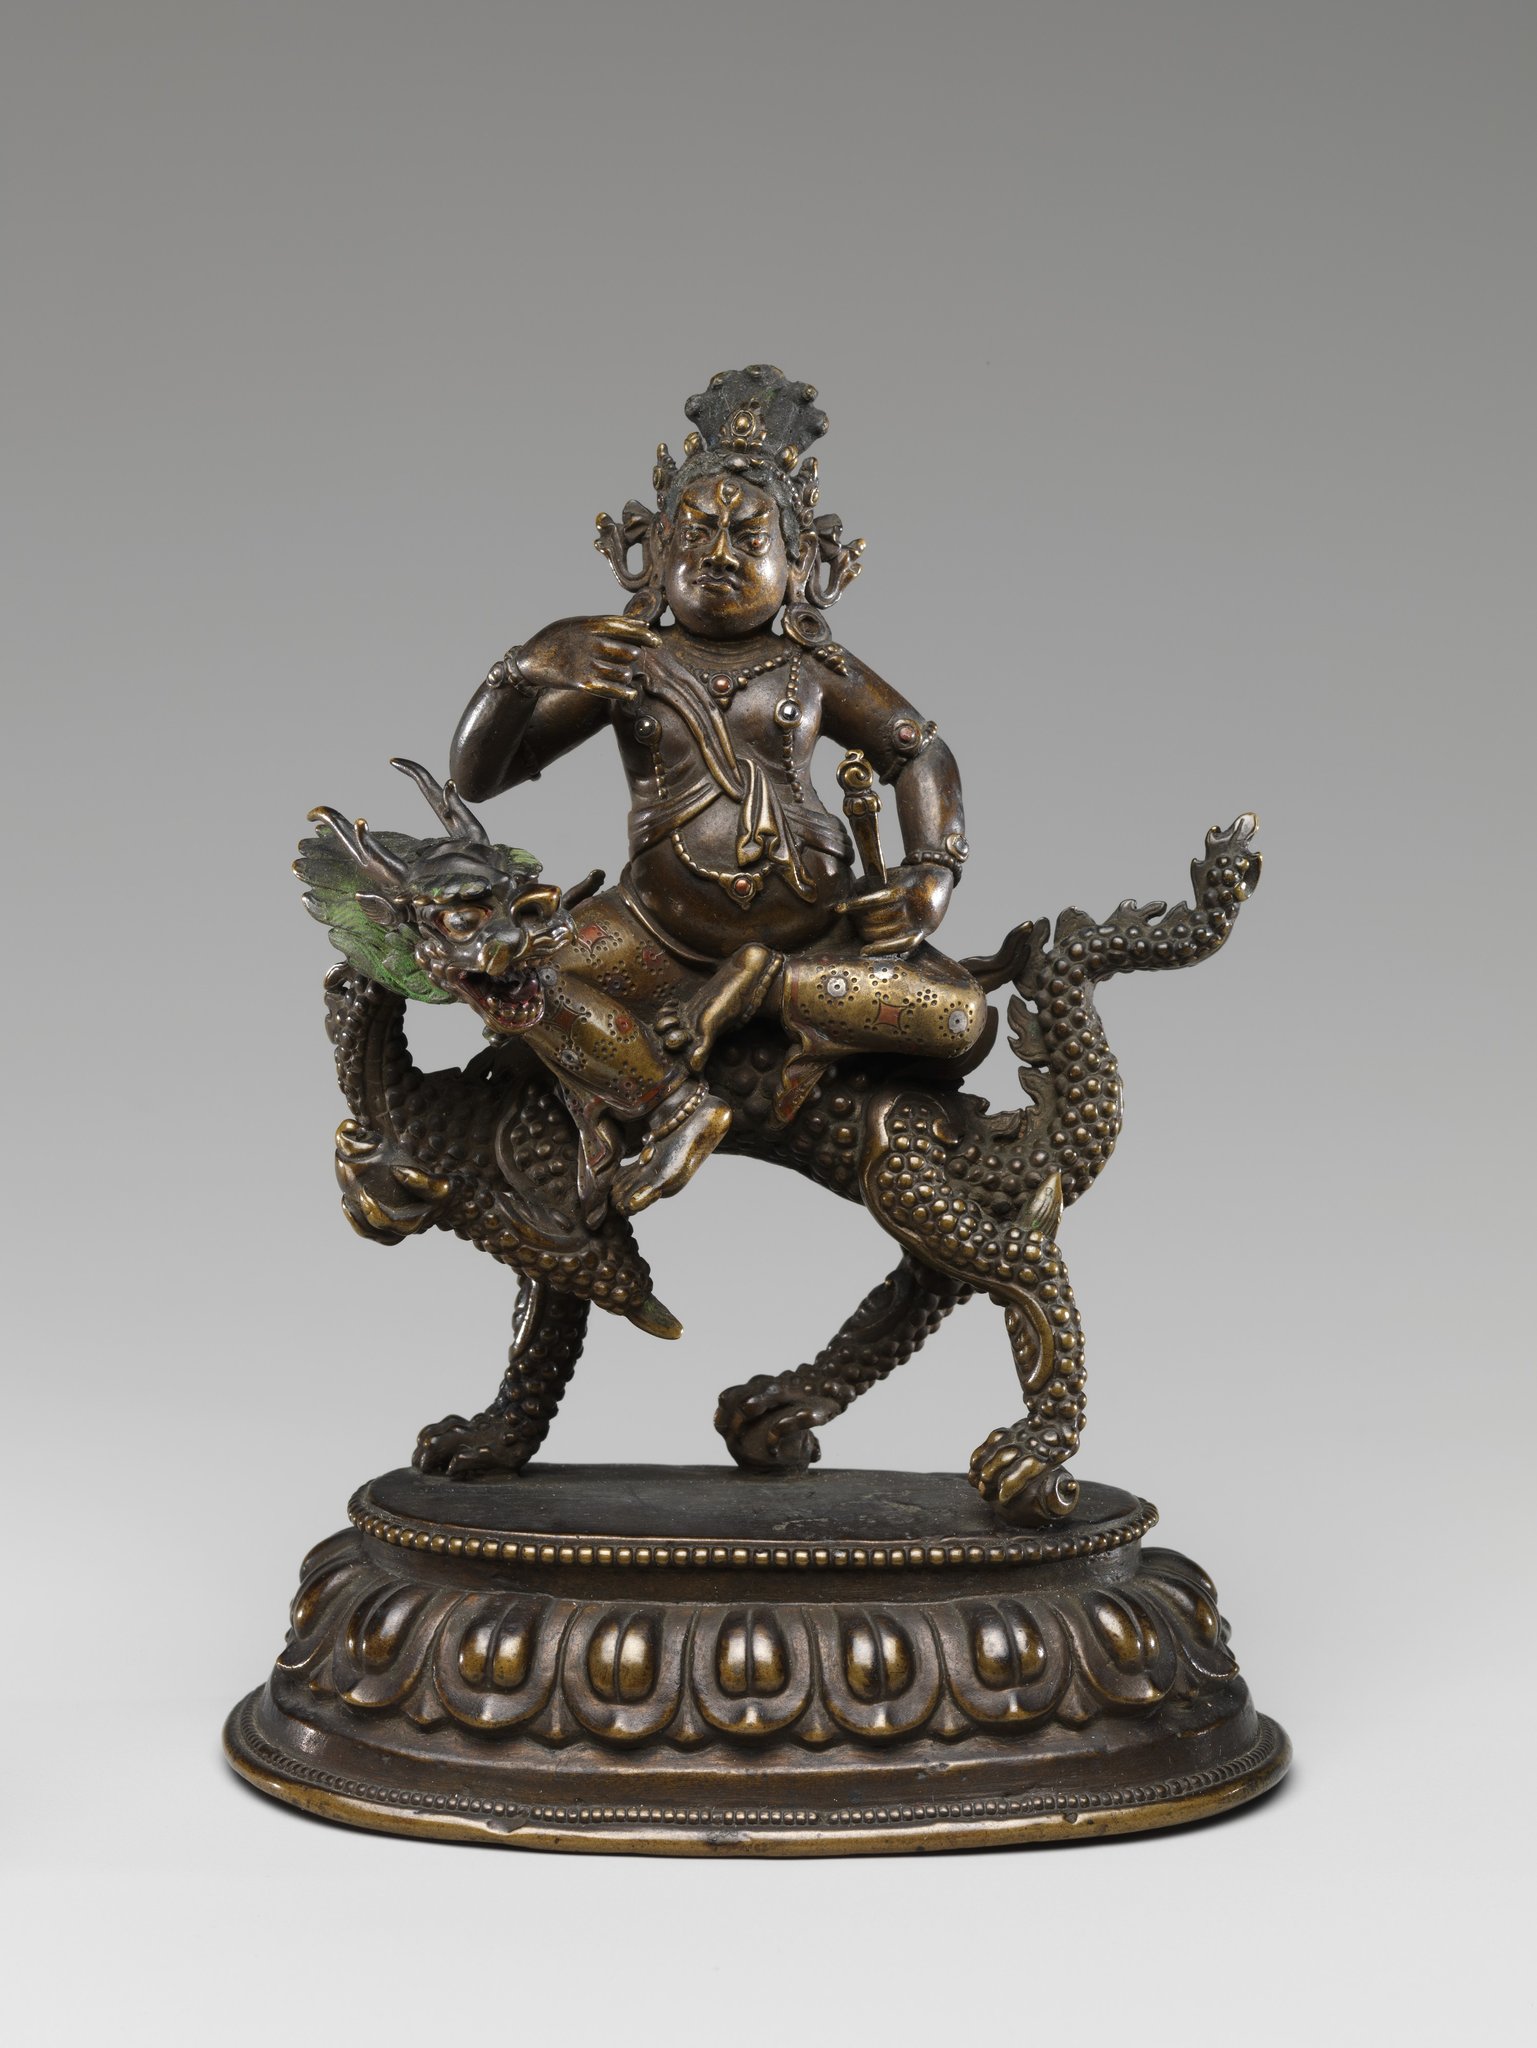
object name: figure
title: White Jambhala on a Dragon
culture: mongolian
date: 1701-1900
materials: brass, copper, pigment, silver, wax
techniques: casting, inlay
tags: dragons